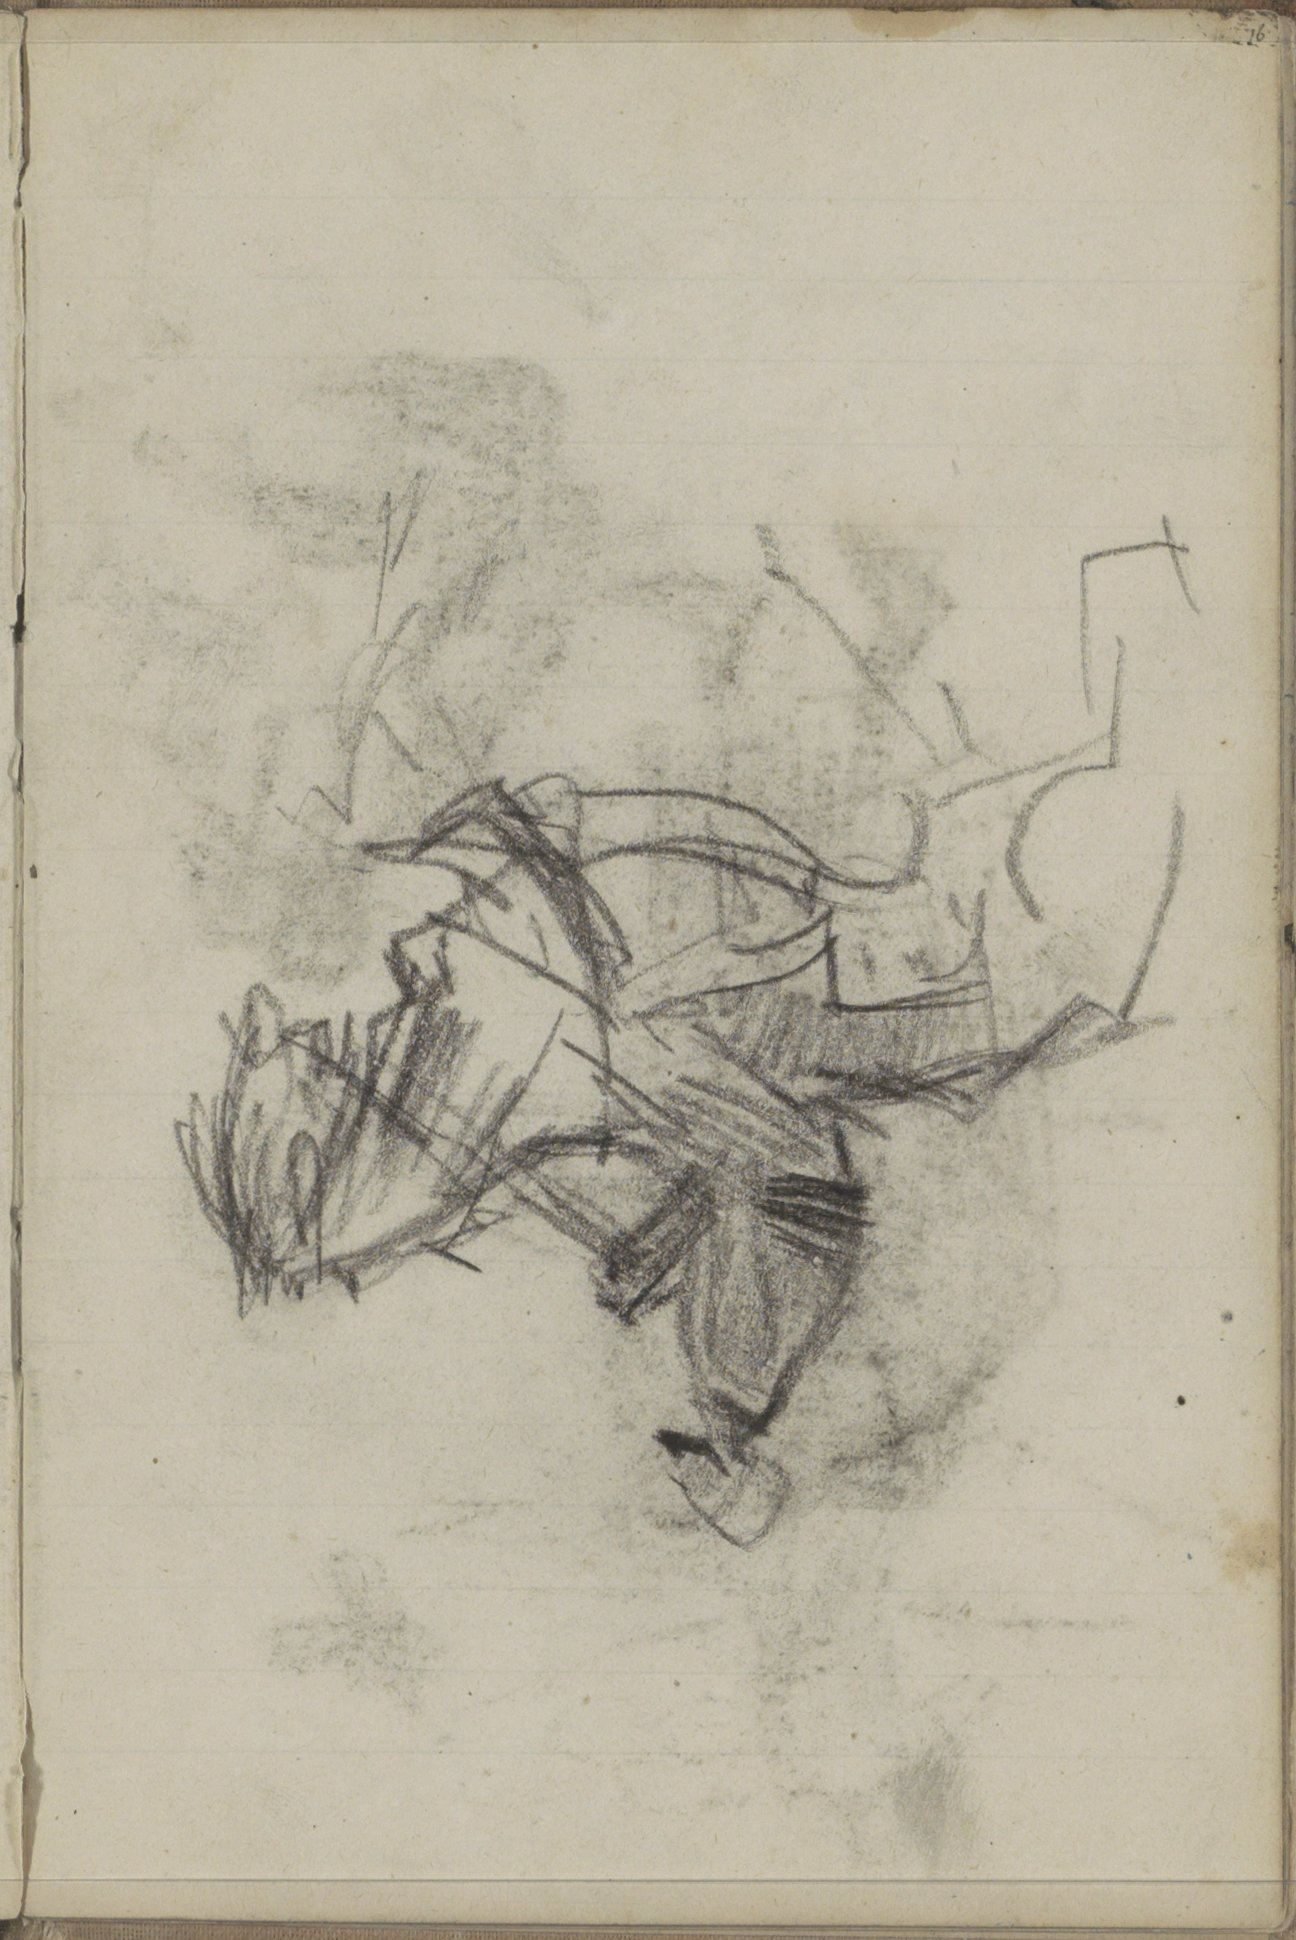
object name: sketchbook leaf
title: Ruiter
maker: marius bauer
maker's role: draughtsman, print maker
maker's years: 1867-1932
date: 1888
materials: chalk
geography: istanbul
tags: riding a horse, ass, or mule; rider, horseman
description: Pagina 76 uit een schetsboek met 58 bladen.